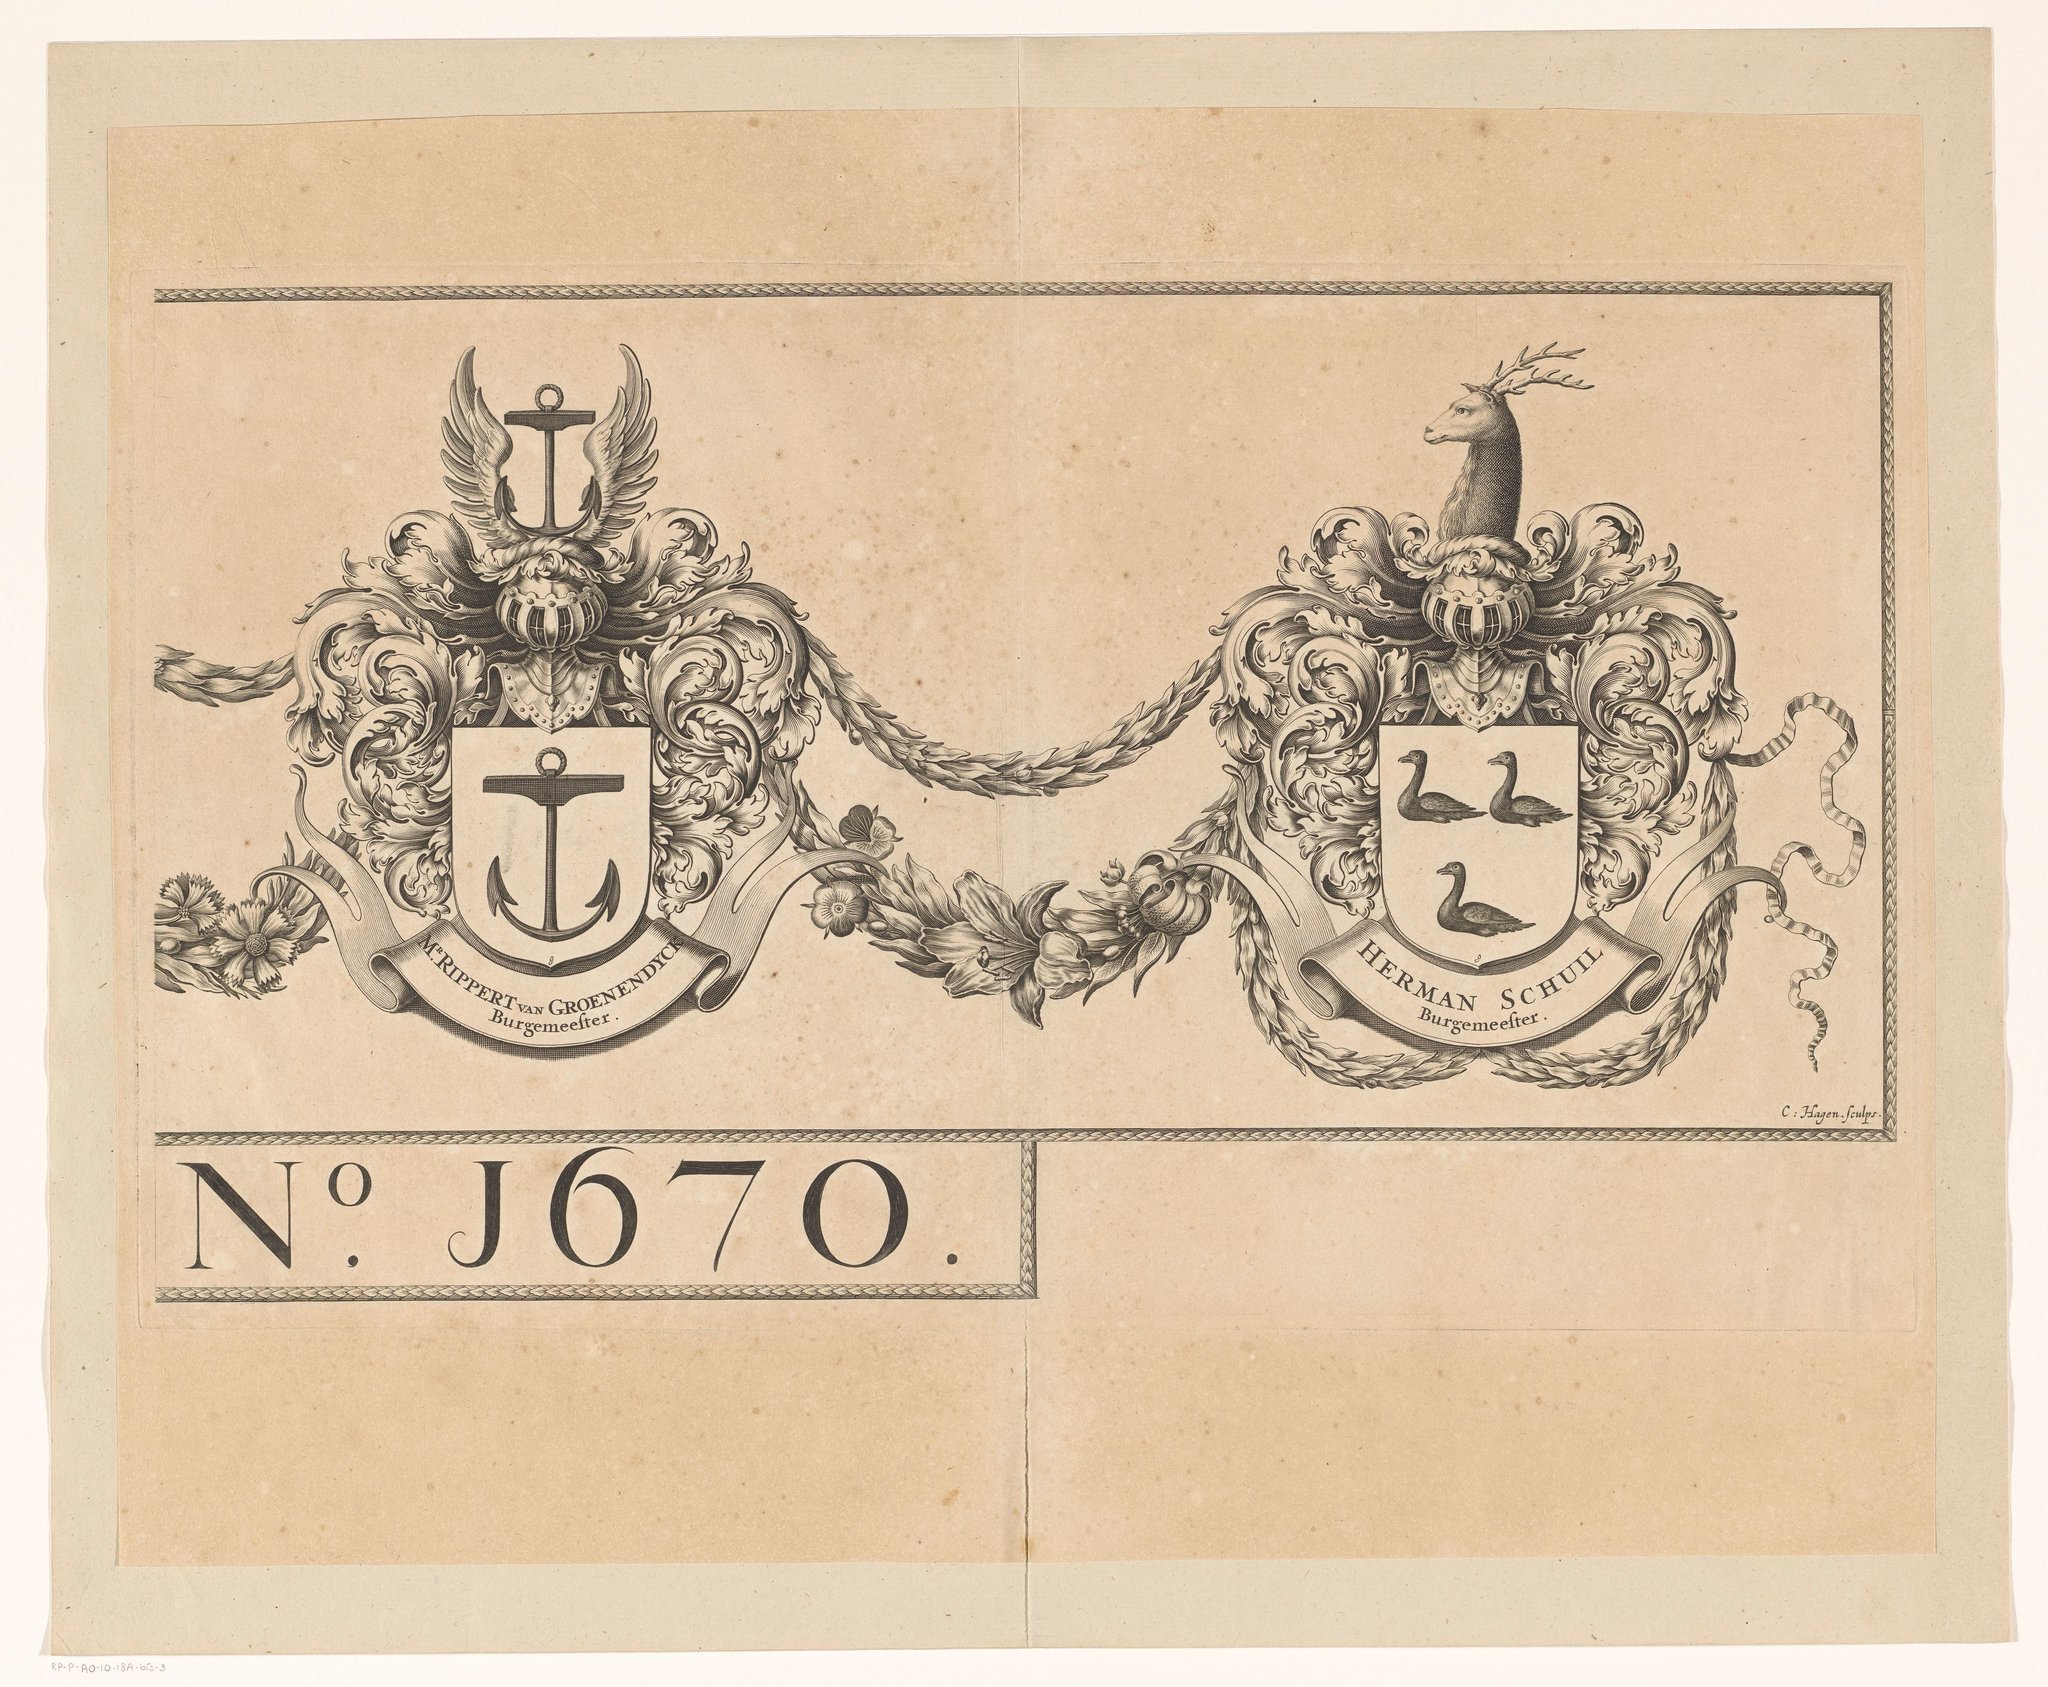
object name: print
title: Rand van de Grote Hagen (rechterblad bovenkant)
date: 1675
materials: paper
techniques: engraving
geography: amsterdam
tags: mayor, armorial bearing, heraldry, leiden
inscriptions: collector's mark: Lugt 2228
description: Deze prent is oorspronkelijk bedoeld als onderdeel van de rand van de zogenaamde Grote Hagen, een wandkaart van Leiden uit 1675. Deze wandkaart bestaat uit een plattegrond van Leiden met daaromheen een rand (met boven de titel en de wapens van de stad en de burgemeesters, langs de zijkanten afbeeldingen van gebouwen in de stad en onder een stadsprofiel). De plattegrond is gedrukt van vier platen, de rand van veertien. Hoewel het jaartal 1670 in de titel staat en de wapens aan de bovenkant van de vier in 1670 zittende burgemeesters zijn, blijkt uit archiefonderzoek dat deze wandkaart pas in 1675 voor het eerst is gedrukt en uitgegeven (zie documentatie voor meer informatie). Voor een digitaal gemonteerde versie van de hele rand zie koepelrecord. Voor een digitaal gemonteerde versie van de bovenkant van de rand zie RP-P-AO-10-18A-A. Voor een digitaal gemonteerde versie van de onderkant van de rand zie RP-P-AO-10-18A-B. Voor een digitaal gemonteerde versie van een latere druk van de plattegrond zie RP-P-AO-10-18. Voor een digitaal gemonteerde versie van de Kleine Hagen zie RP-P-AO-10-81.